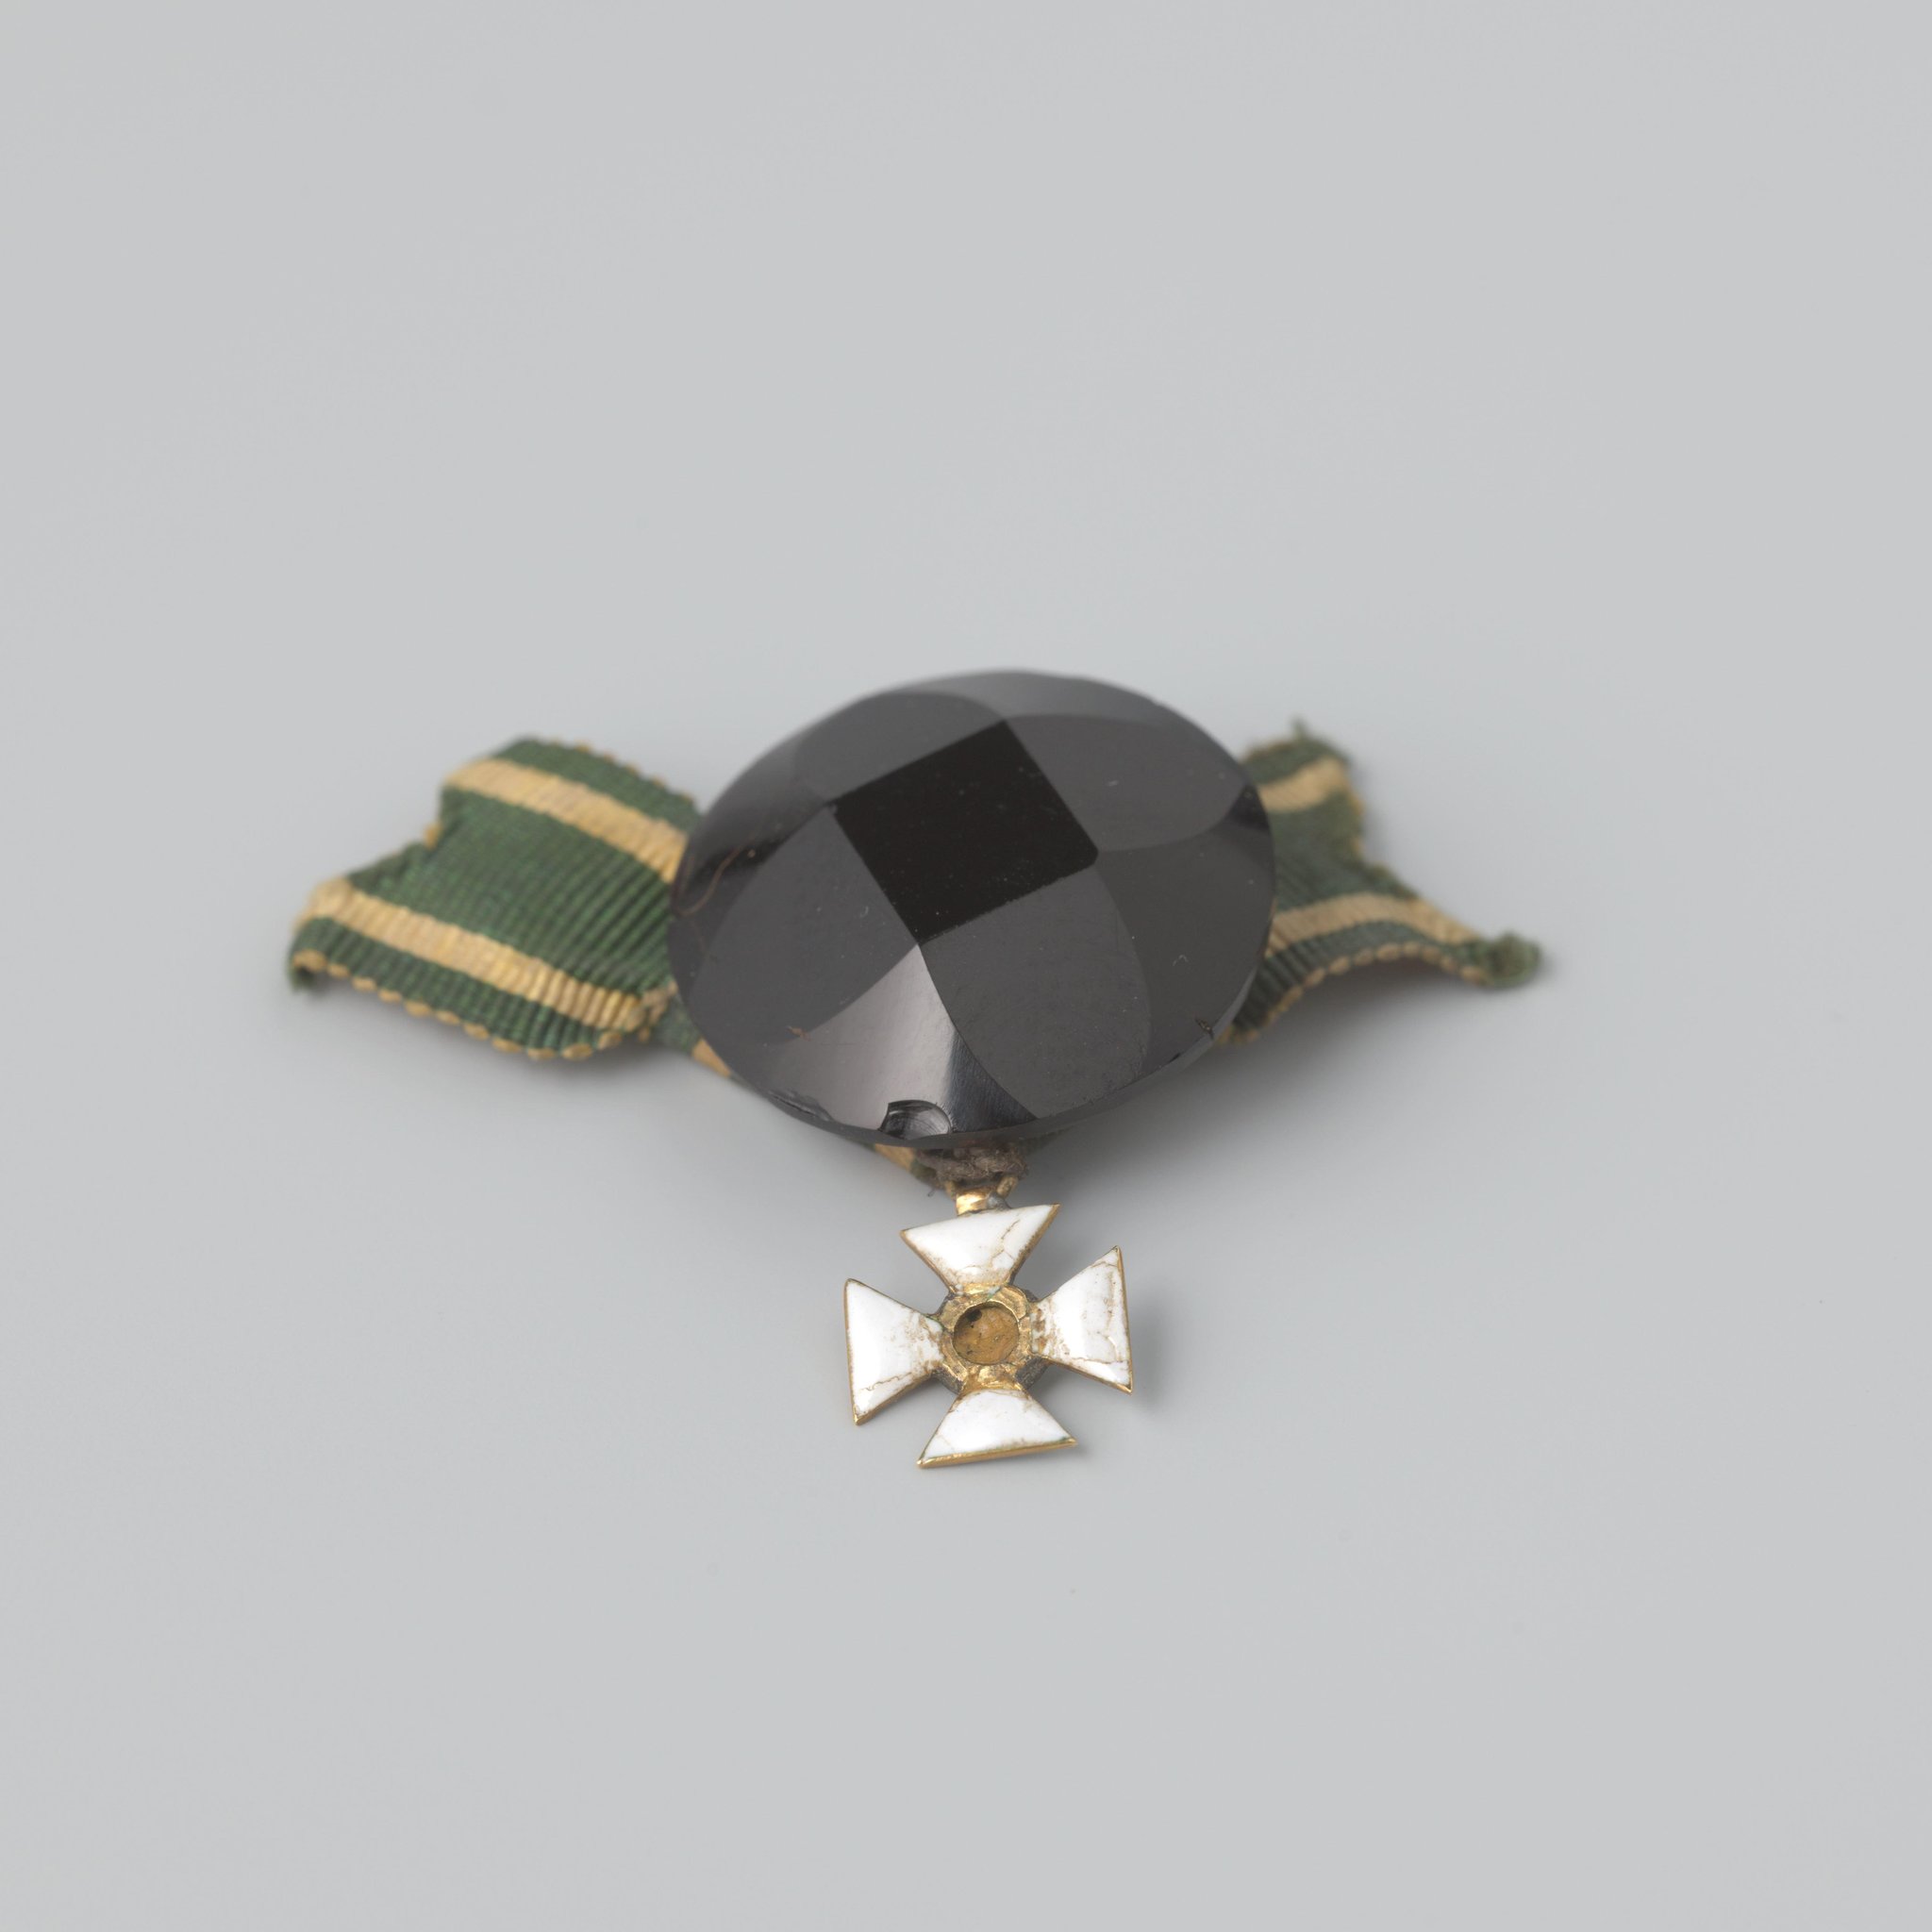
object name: history medal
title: Orde van de Eikenkroon, miniatuur aan knoop, gedragen door Nicolaas Pieneman.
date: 1840-1860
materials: cardboard, glass, silver, textile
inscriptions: inscription: ‘Orde van den Ei- / kenkroon, ge- / dragen door / Nic. Pieneman’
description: Gouden (verguld?) miniatuur kruis met wit geëmailleerde benen en ronde groen geëmaillerde hartplaat waarop een gekroonde letter W, de hartplaat op de keerzijde ontbrekend, met oog en draagring, aan een strik van donkergroen lint met twee witte strepen, met garen vastgemaakt aan een zwart glazen knoop, onder watten in een ovaal kartonnen doosje, aan de zijkant beplakt met lichtgroen papier en bovenop een etiket waarop met inkt de herkomst staat beschreven.